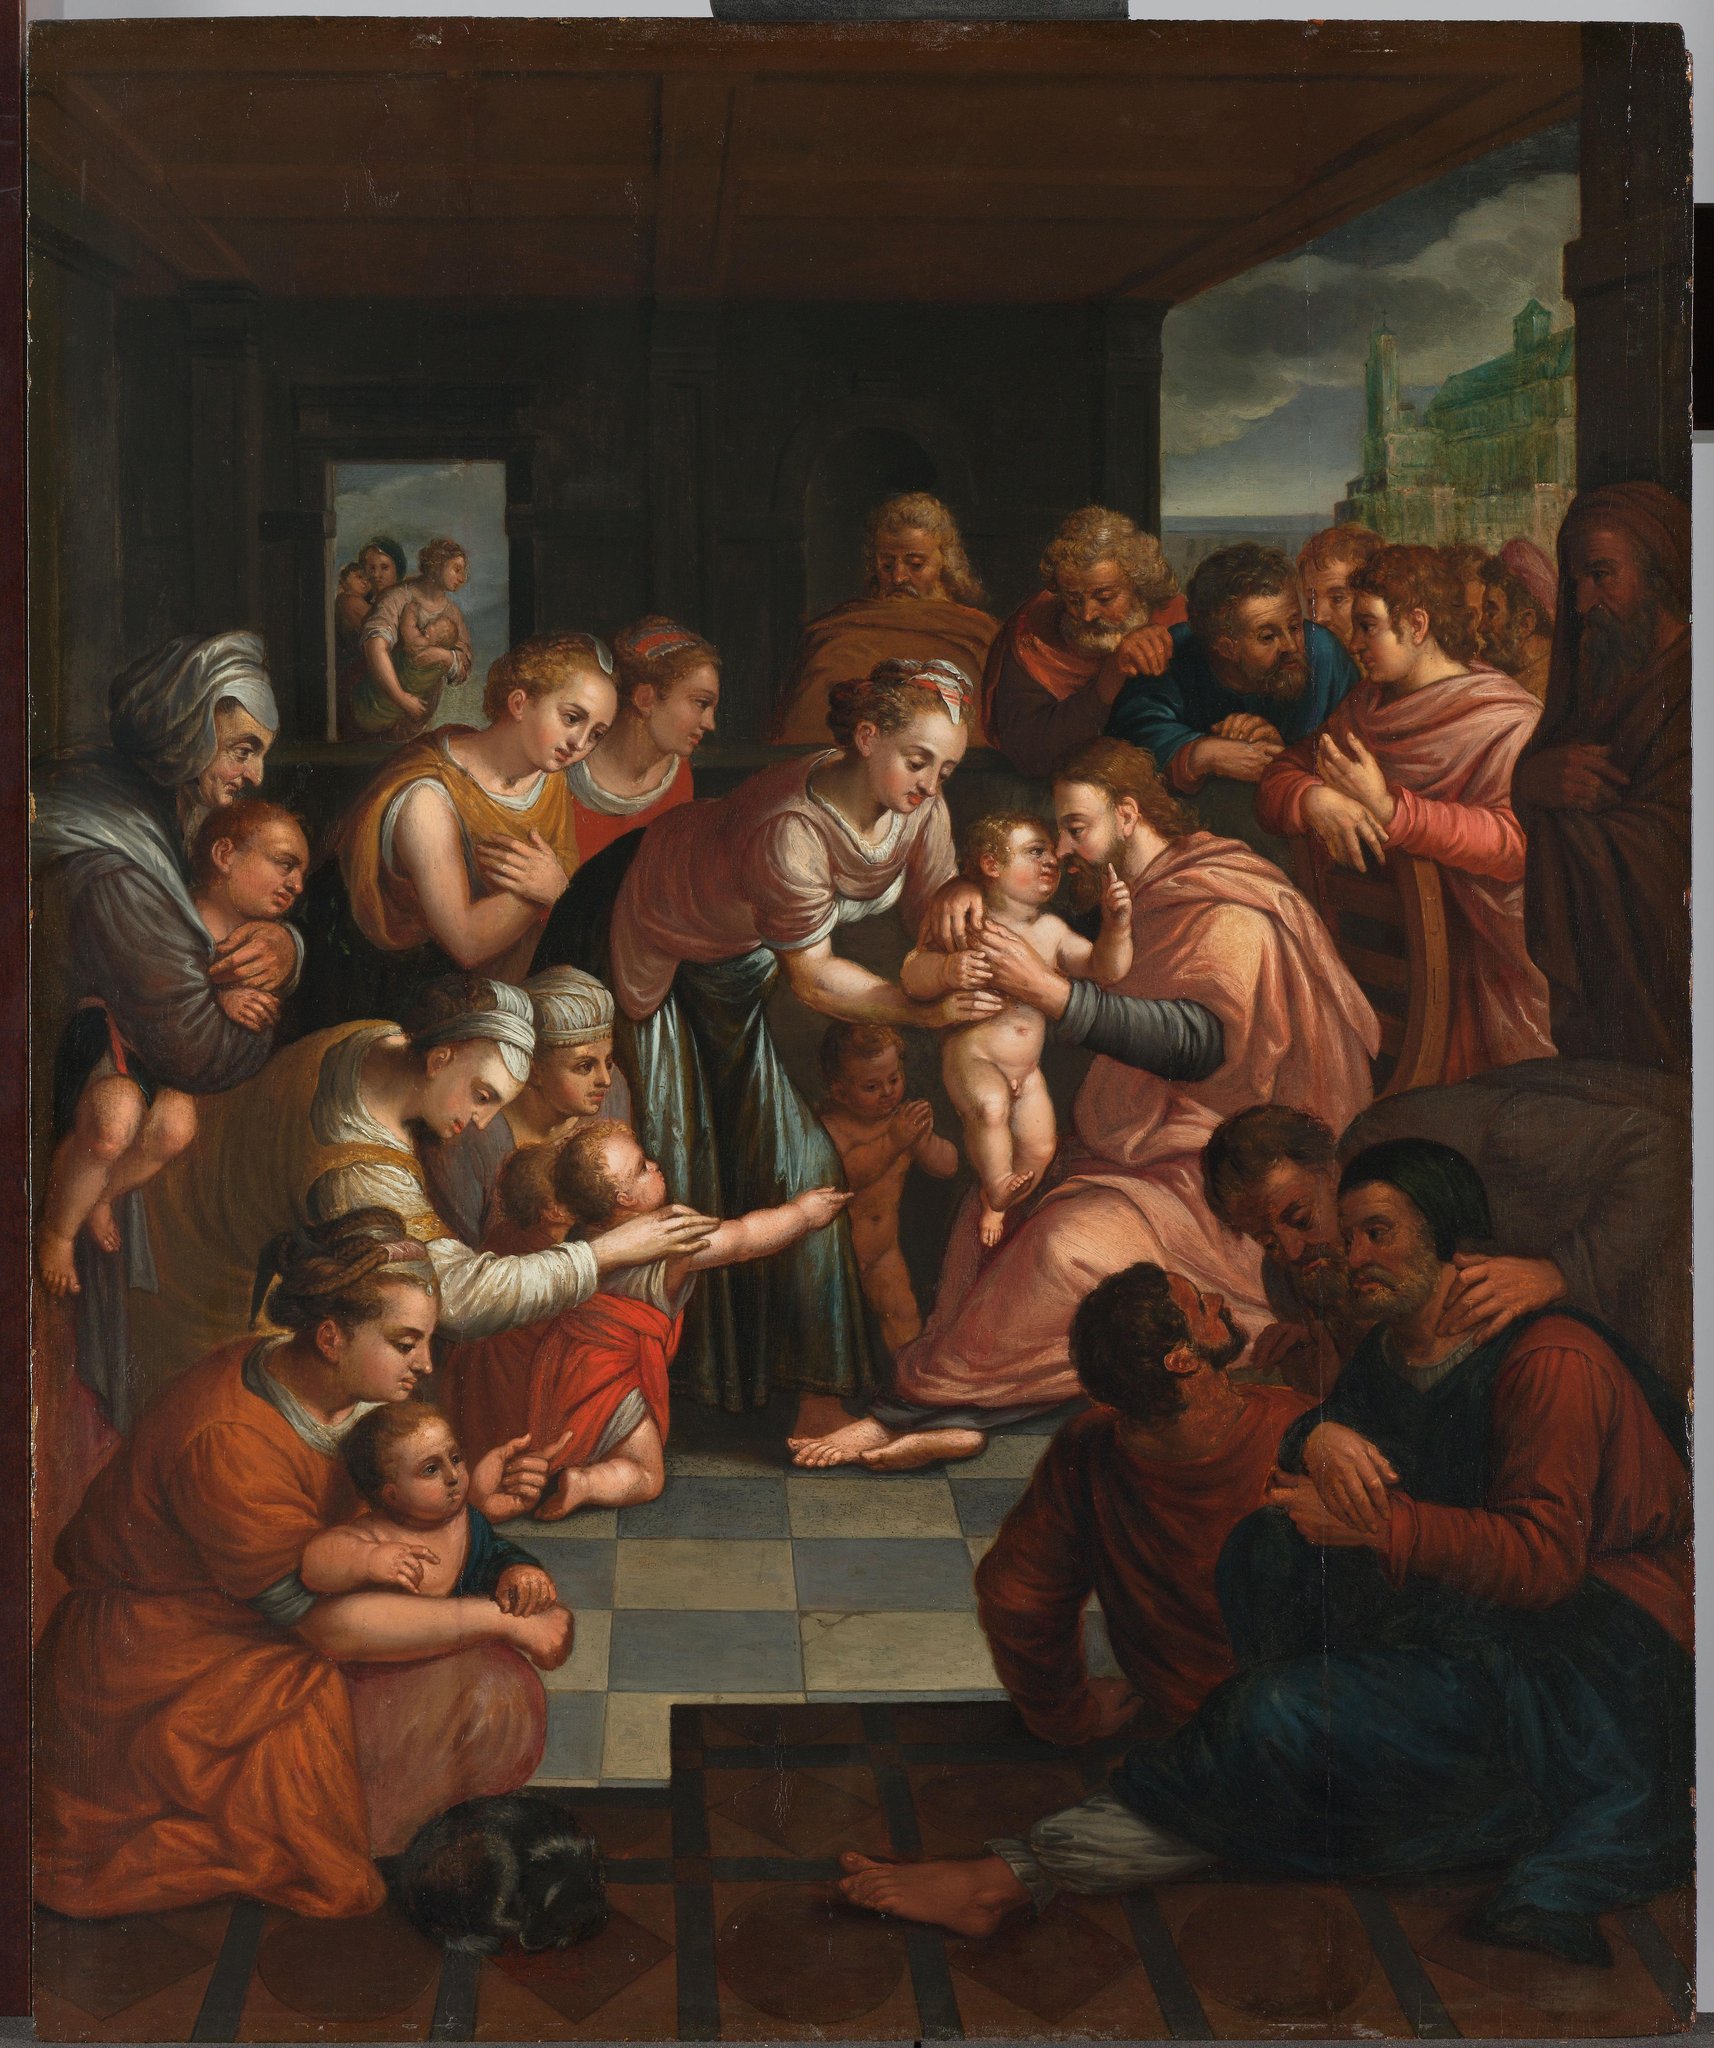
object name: painting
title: Christ Blessing the Children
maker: Anonymous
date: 1570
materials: oil, panel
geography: southern netherlands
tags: christ blessing children brought by their mothers, usually with some disciples disapprovingly looking on (matthew 19:13-15; mark 10:13-16; luke 18:15-17)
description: Christus zegent de kinderen die door hun moeders bij hem worden gebracht. Achter Christus kijken de discipelen toe, rechts op de voorgrond zitten enkele schriftgeleerden.